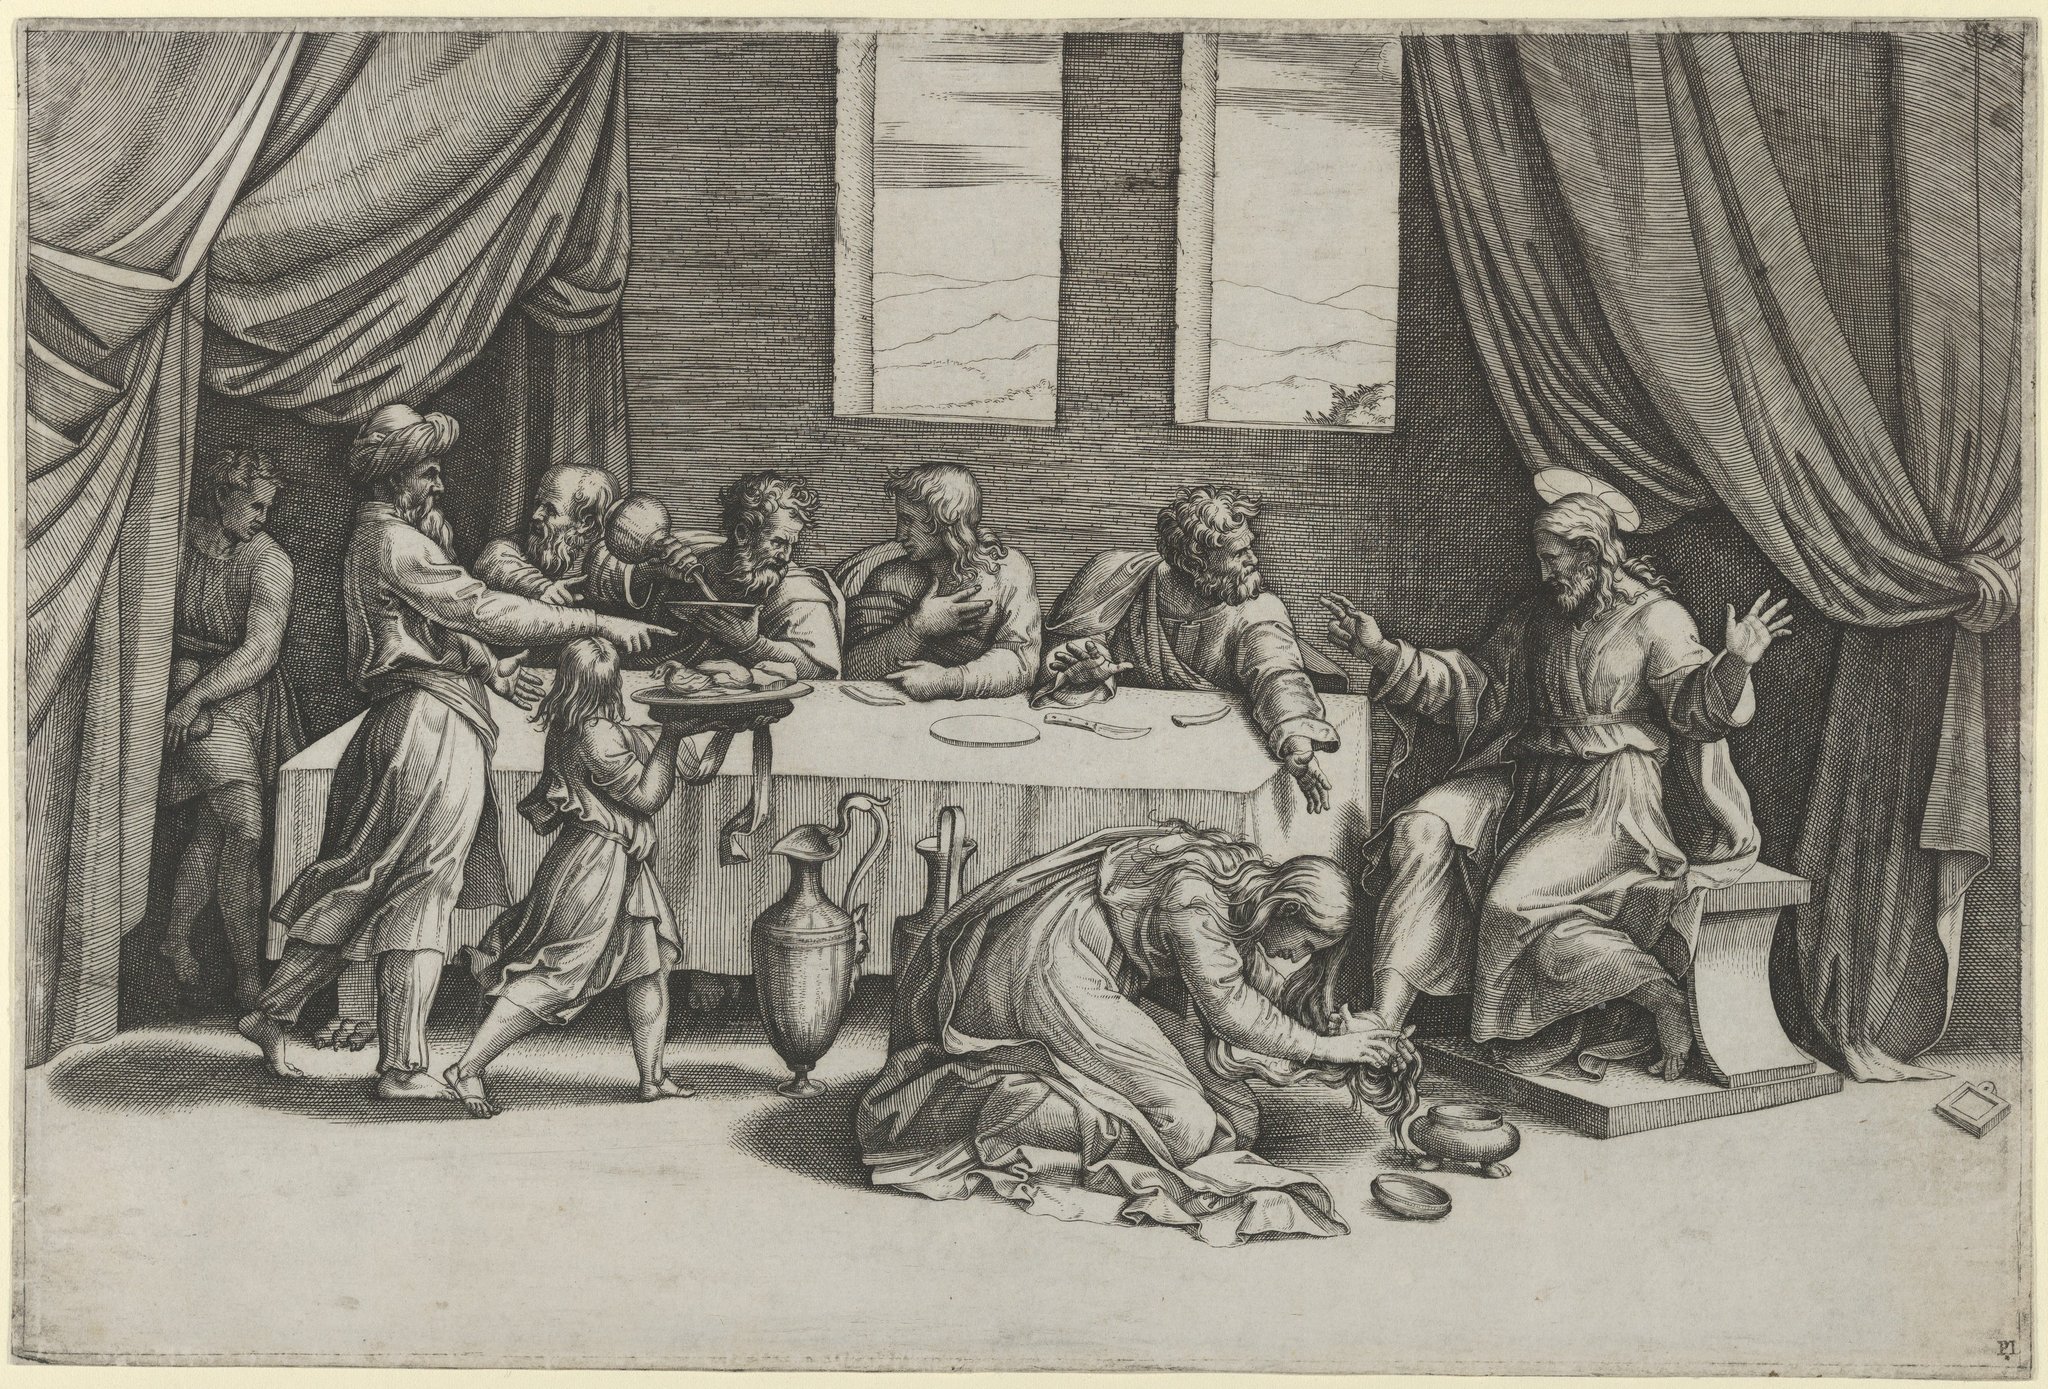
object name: print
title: Christ at the table of Simon the Pharisee, Mary Magdalene washing his feet with her hair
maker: marcantonio raimondi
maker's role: artist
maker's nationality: italian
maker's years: 1475-1534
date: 1520-1525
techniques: engraving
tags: apostles,christ,mary magdalene,tables